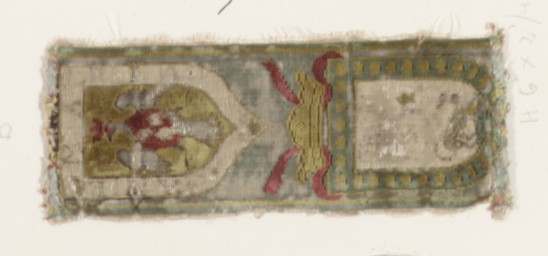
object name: fragment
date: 1501-1600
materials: metal thread, silk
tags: birds,coat of arms